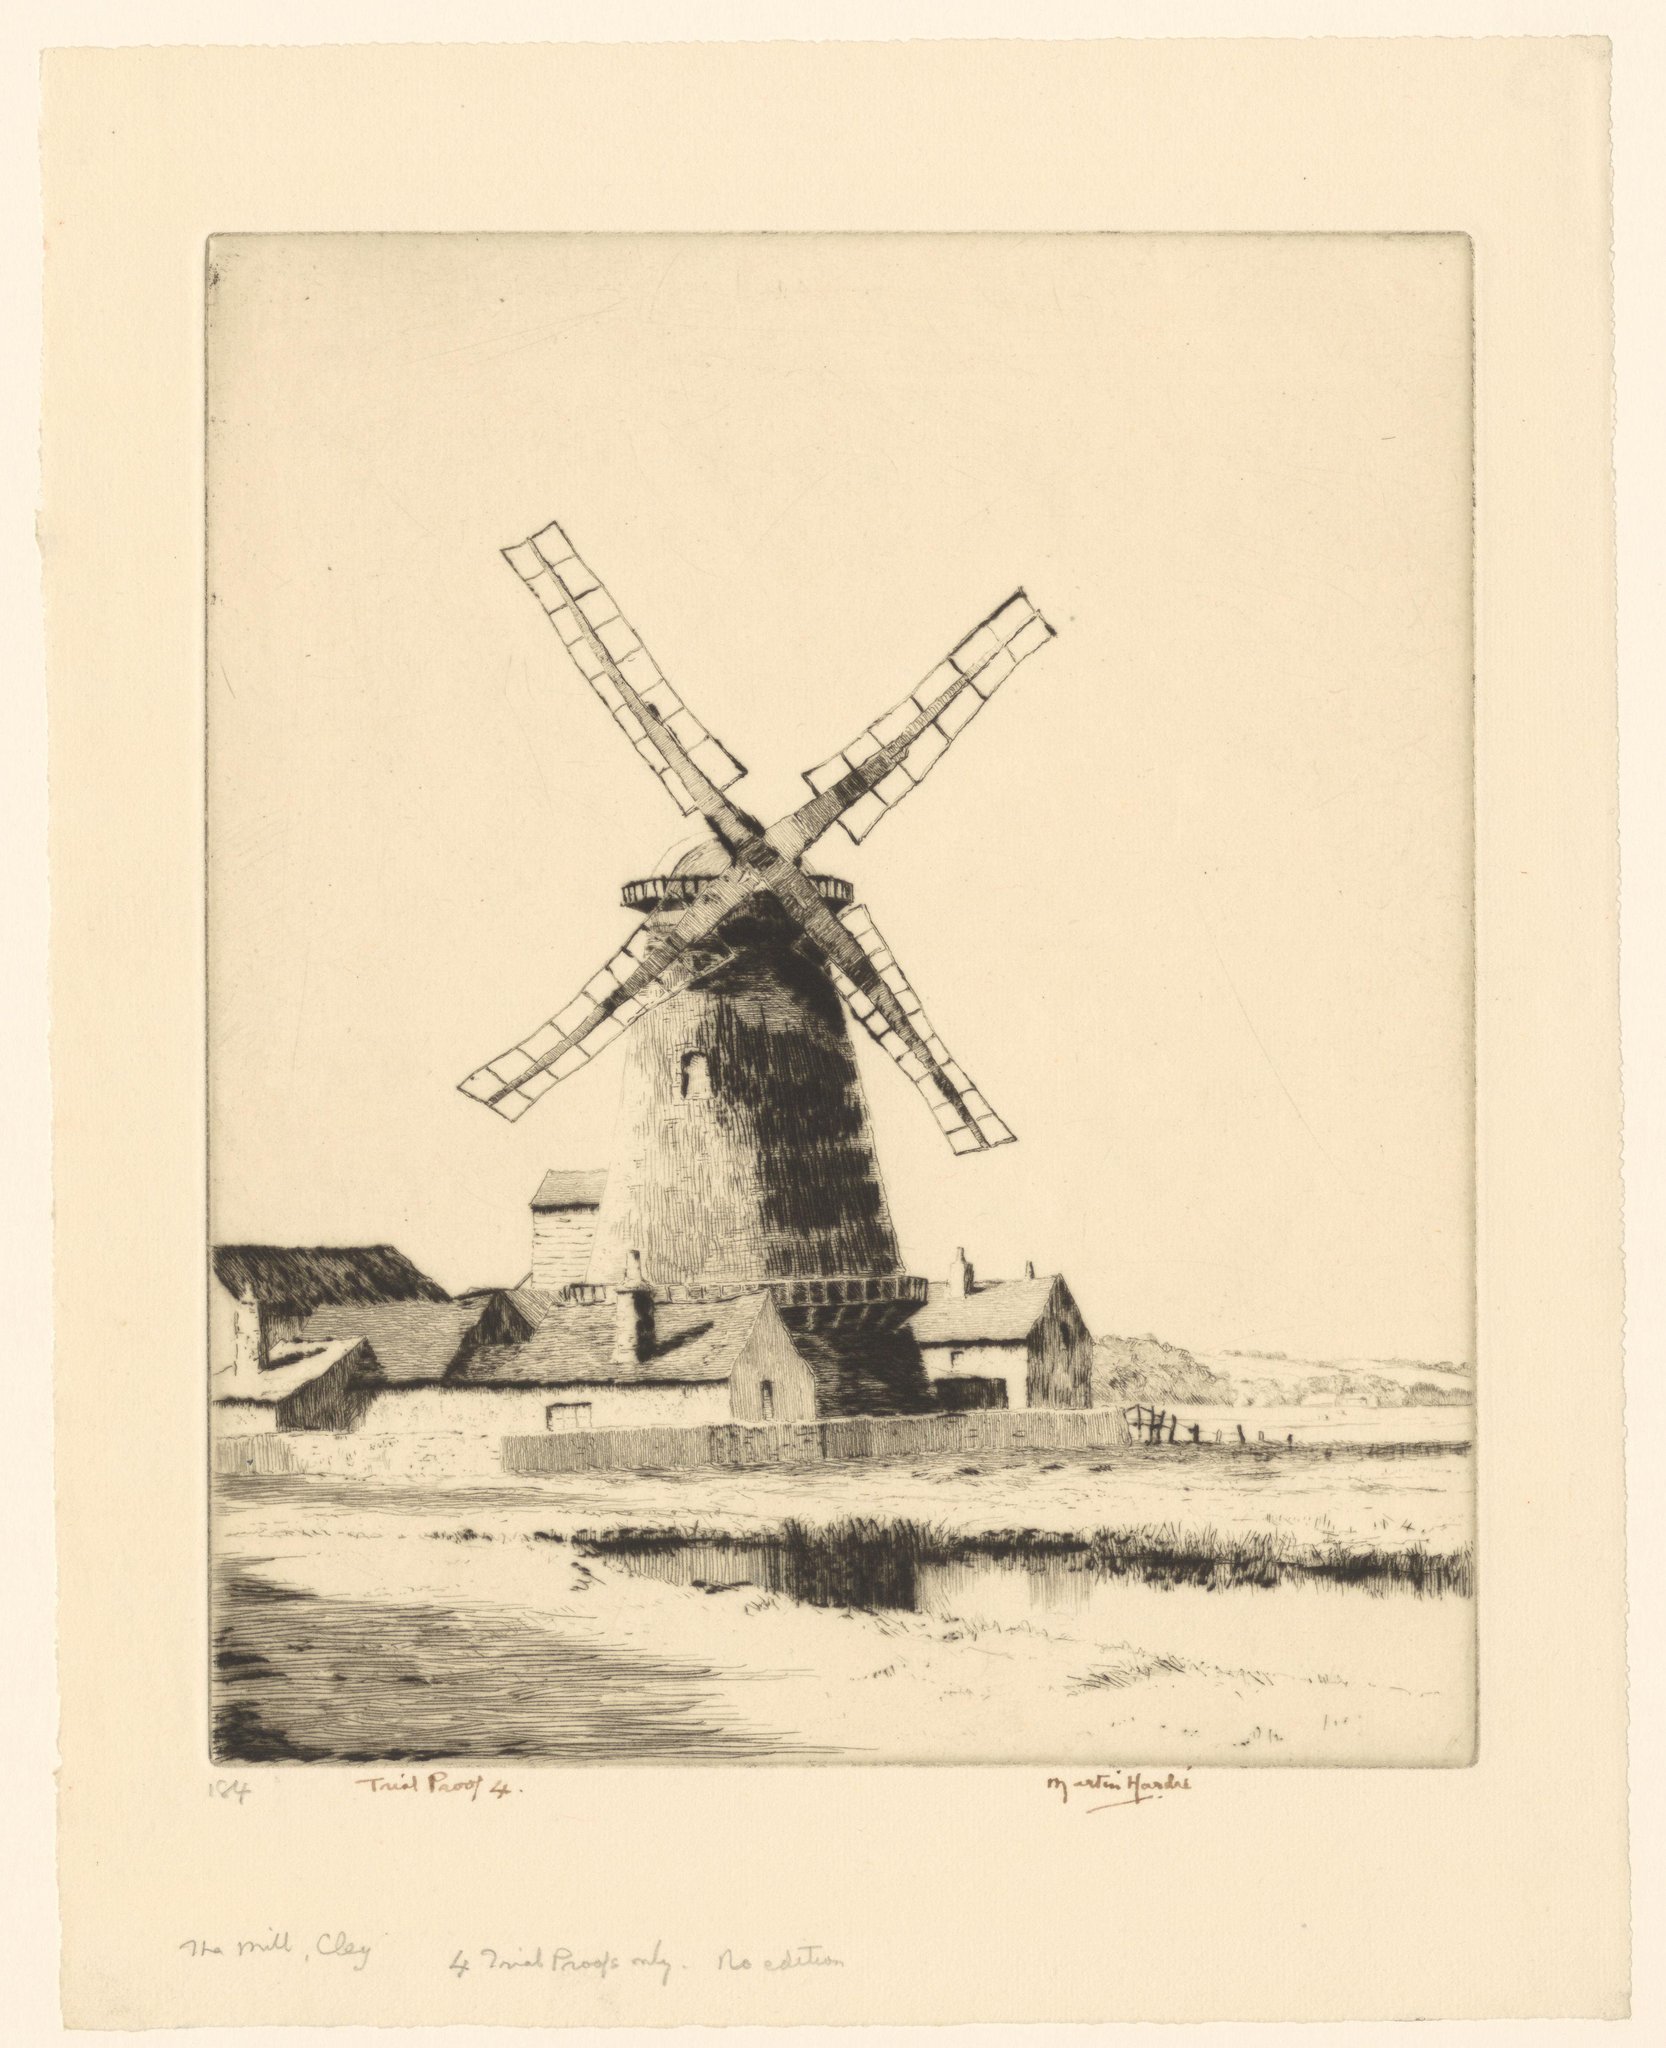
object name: print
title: The Mill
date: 1946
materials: paper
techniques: drypoint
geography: cley next the sea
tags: windmill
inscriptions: collector's mark: Lugt 2228, annotation: ‘Trial Proof 4’, annotation: ‘Martin Hardie’, collector's mark: Lugt 2760